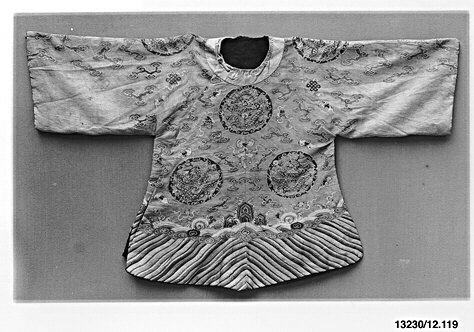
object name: robe, child's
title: Child's Robe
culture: chinese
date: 1801-1900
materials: silk